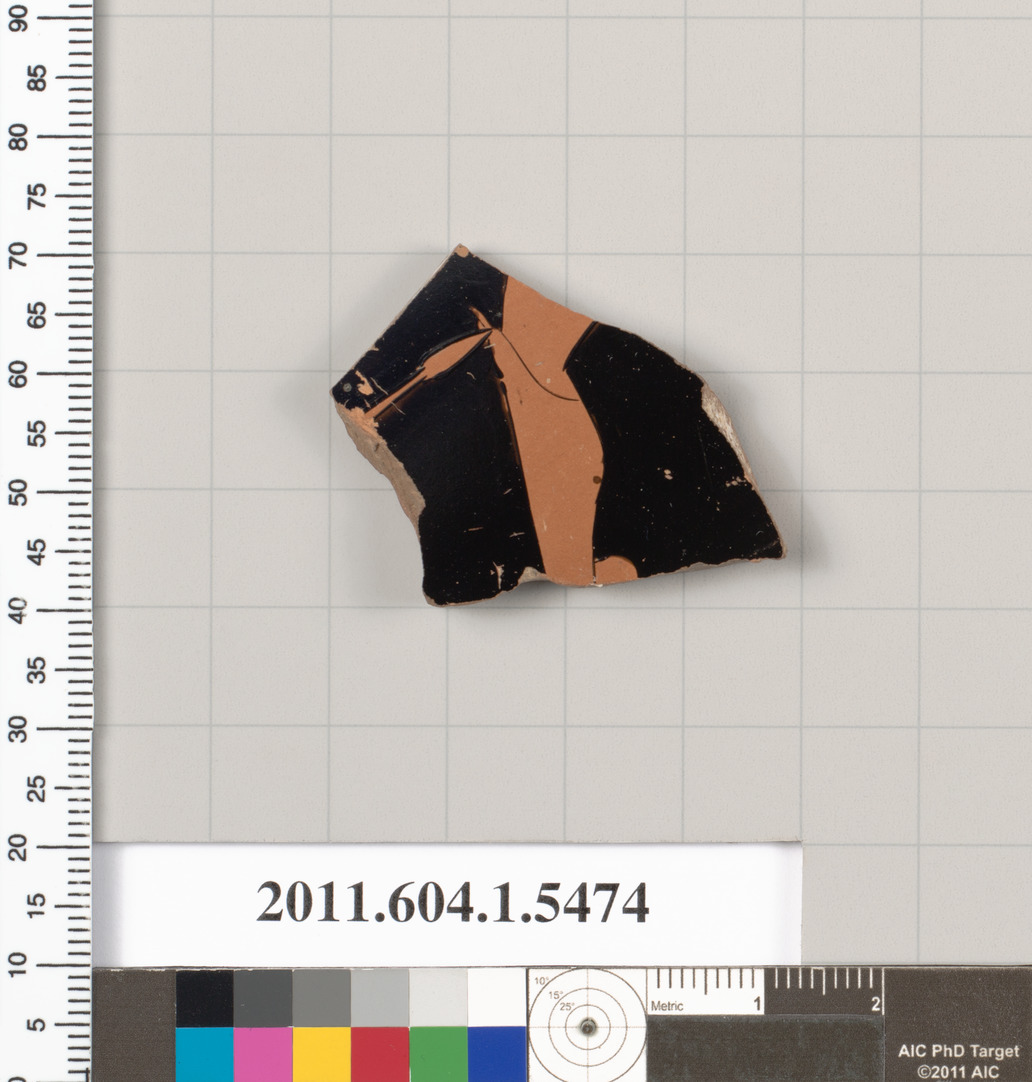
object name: kylix fragment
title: Terracotta fragment of a kylix (drinking cup)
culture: greek, attic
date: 510-490 BCE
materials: terracotta